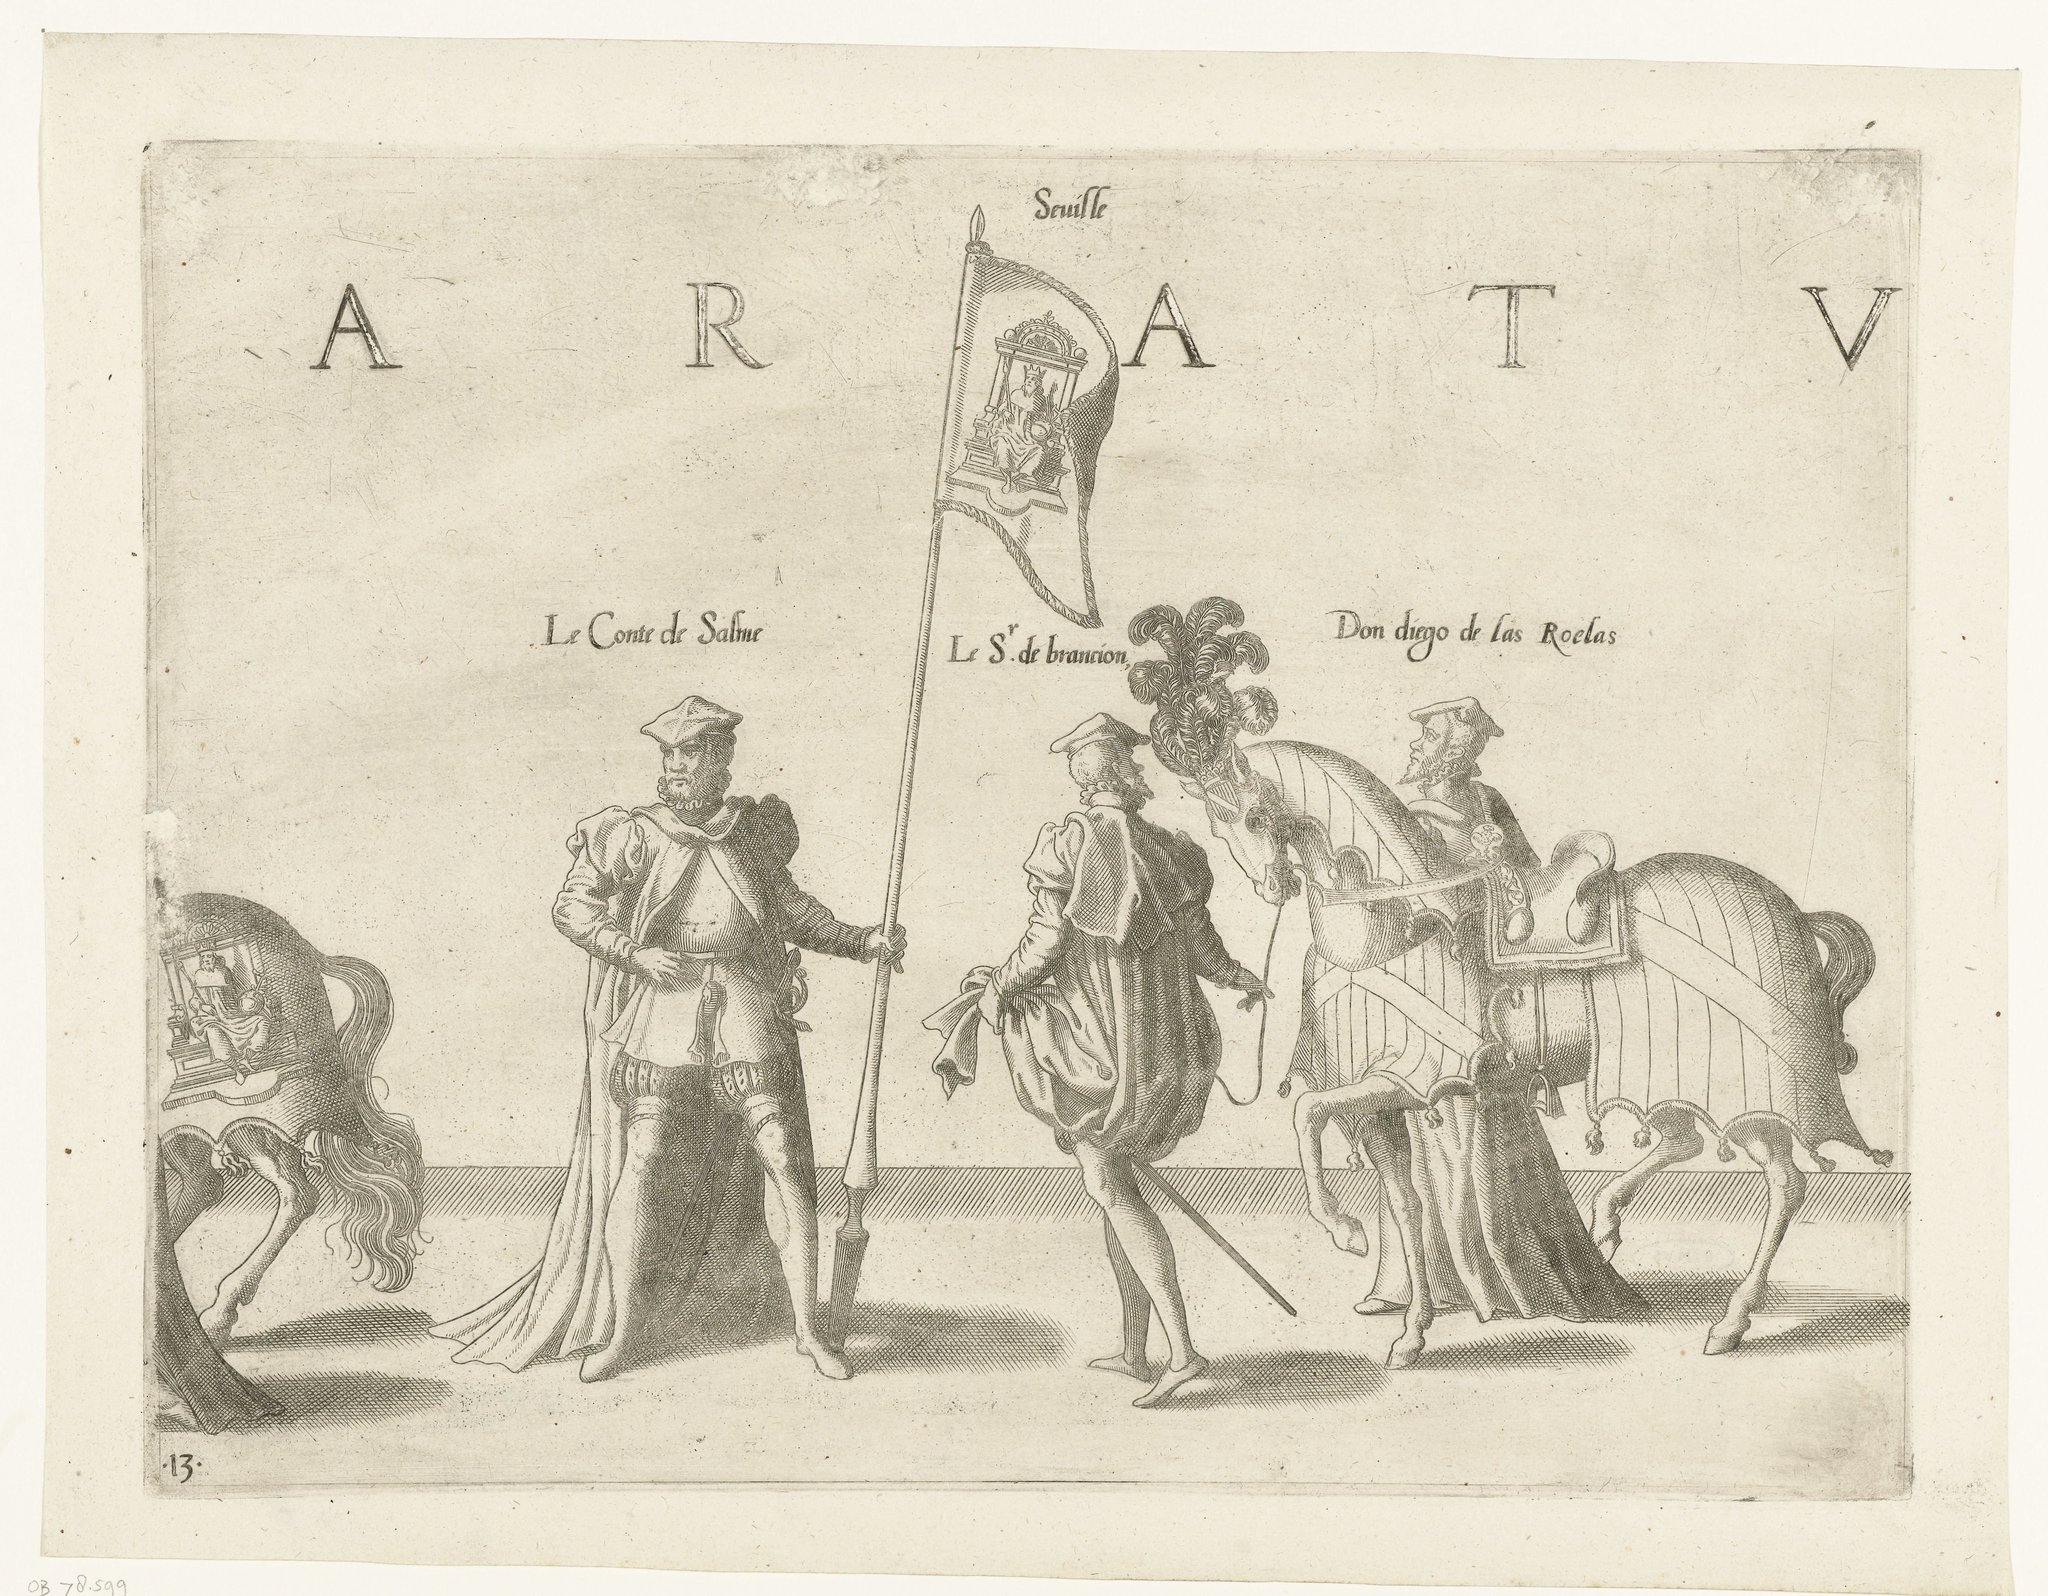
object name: print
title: Begrafenisoptocht van keizer Karel V, 1558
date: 1559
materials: paper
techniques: engraving, etching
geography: southern netherlands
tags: charles v (holy roman emperor and king of spain), cortege, funeral procession, sevilla, brussels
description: Drie deelnemers aan de optocht, paarden en het vaandel met het wapen van Sevilla. Onderdeel van de prentreeks van de Begrafenisoptocht van keizer Karel V op 29 december 1558 te Brussel.